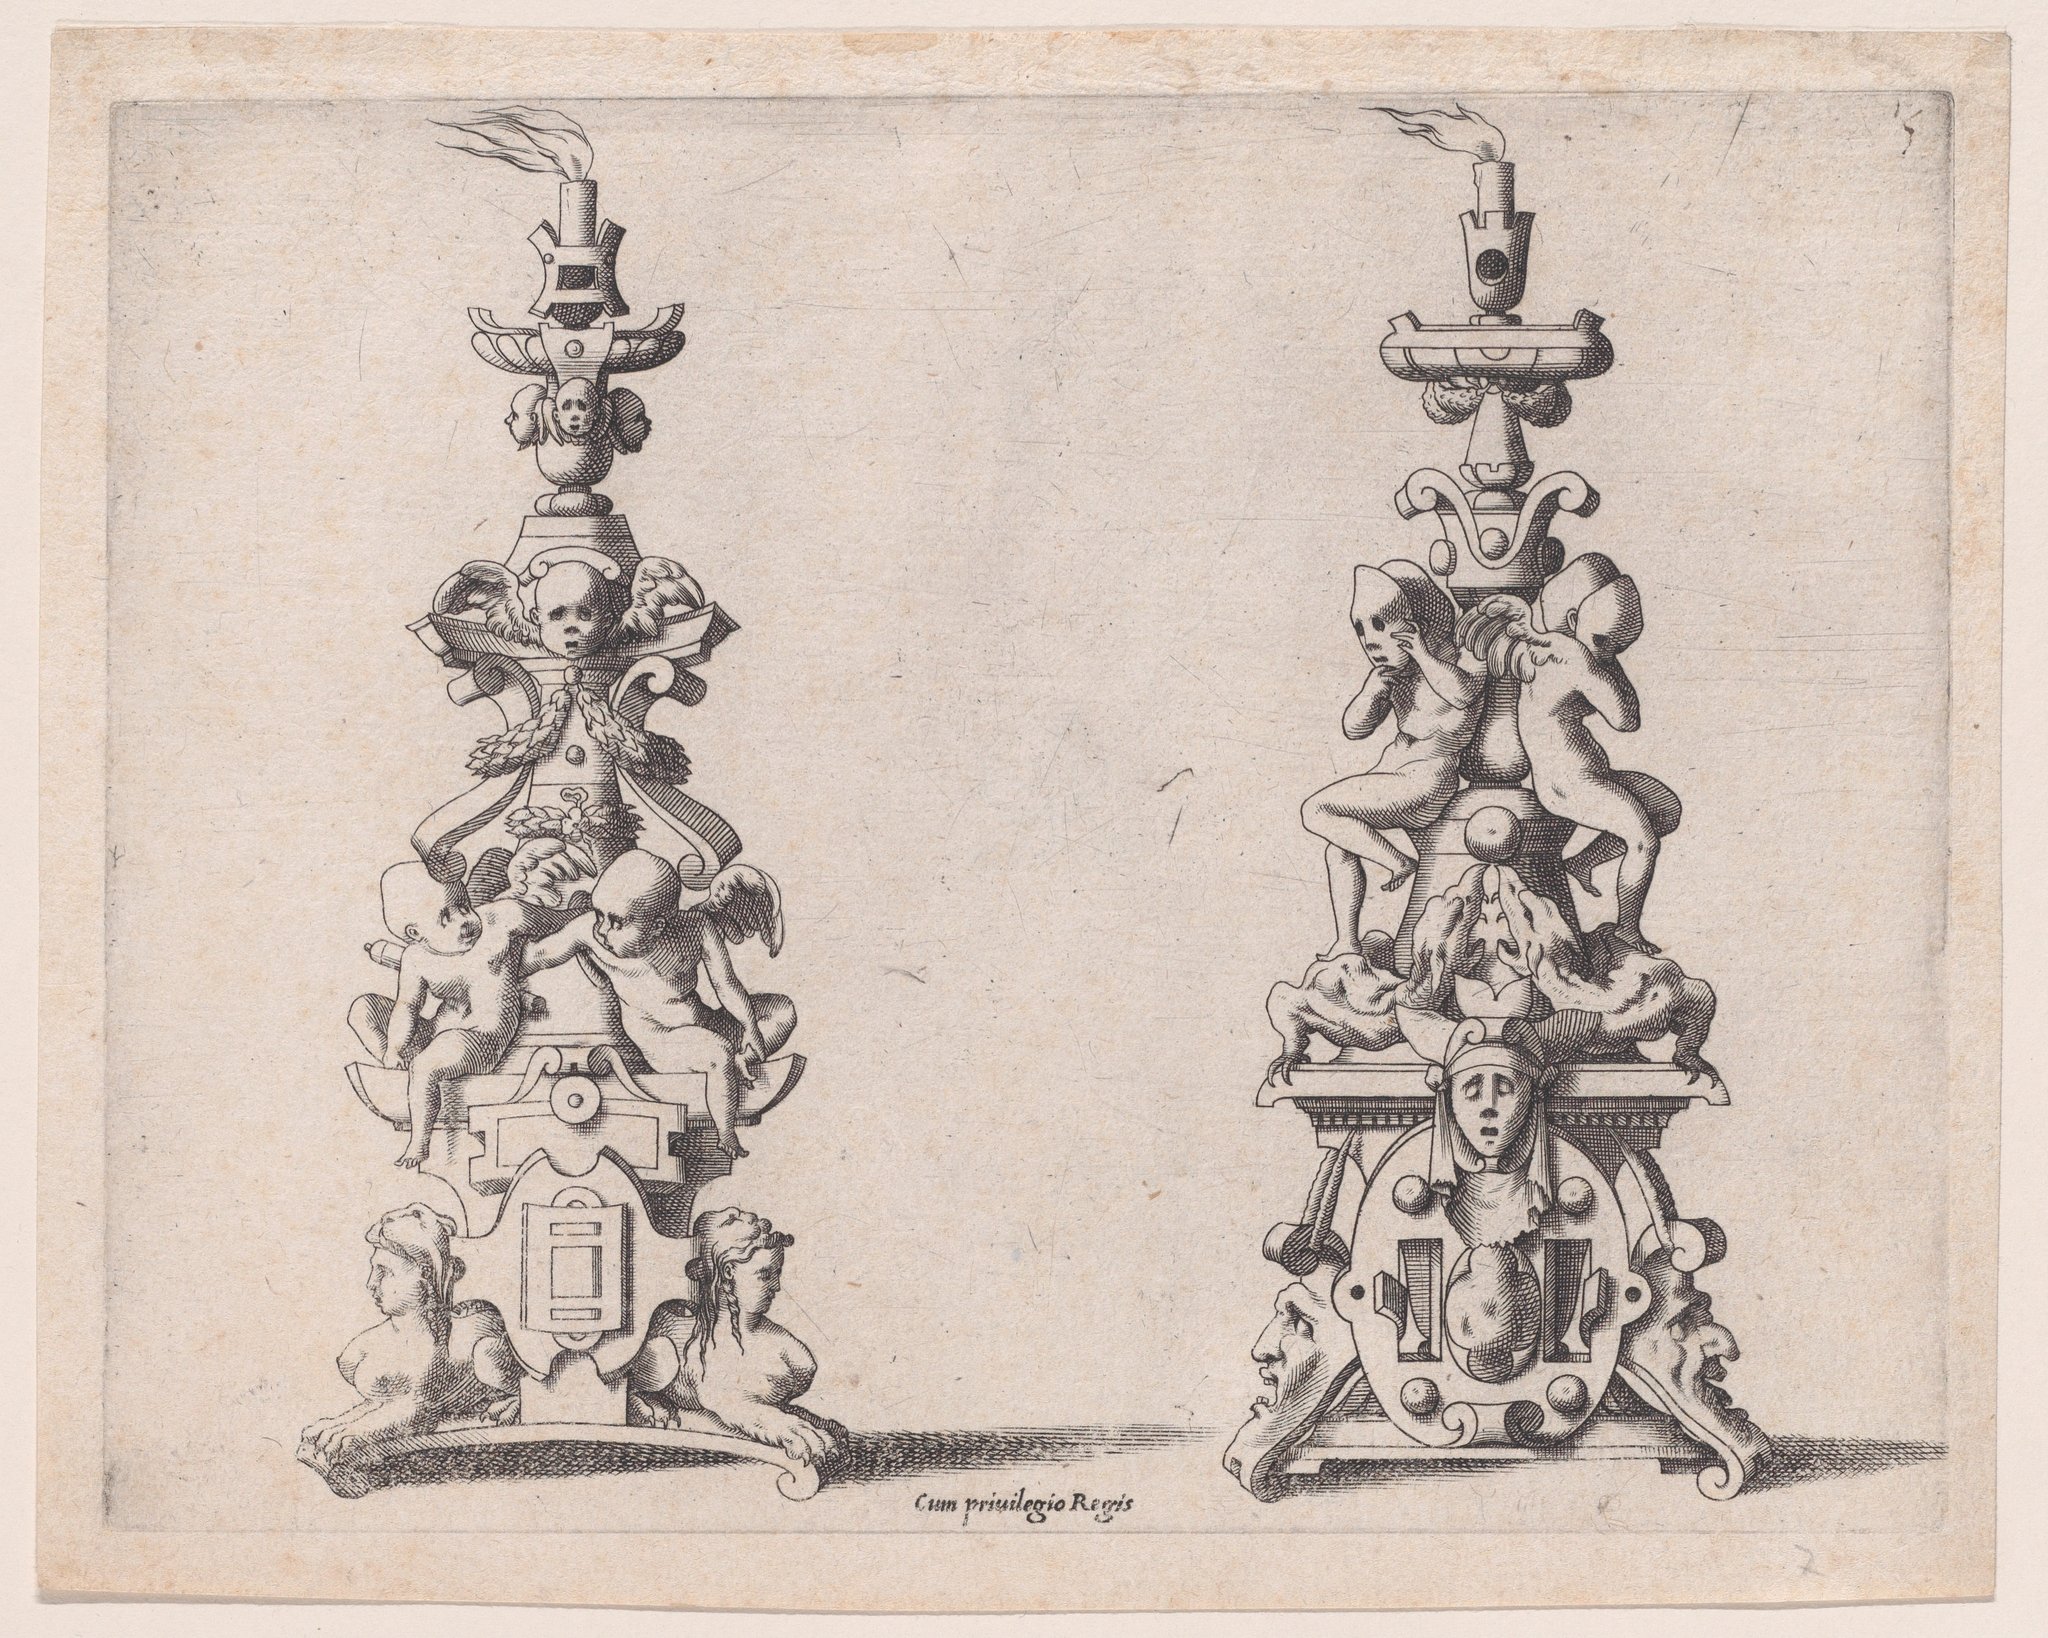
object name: print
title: Two Candlesticks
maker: rené boyvin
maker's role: artist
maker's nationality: french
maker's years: 1525-1598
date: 1525-1600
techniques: engraving